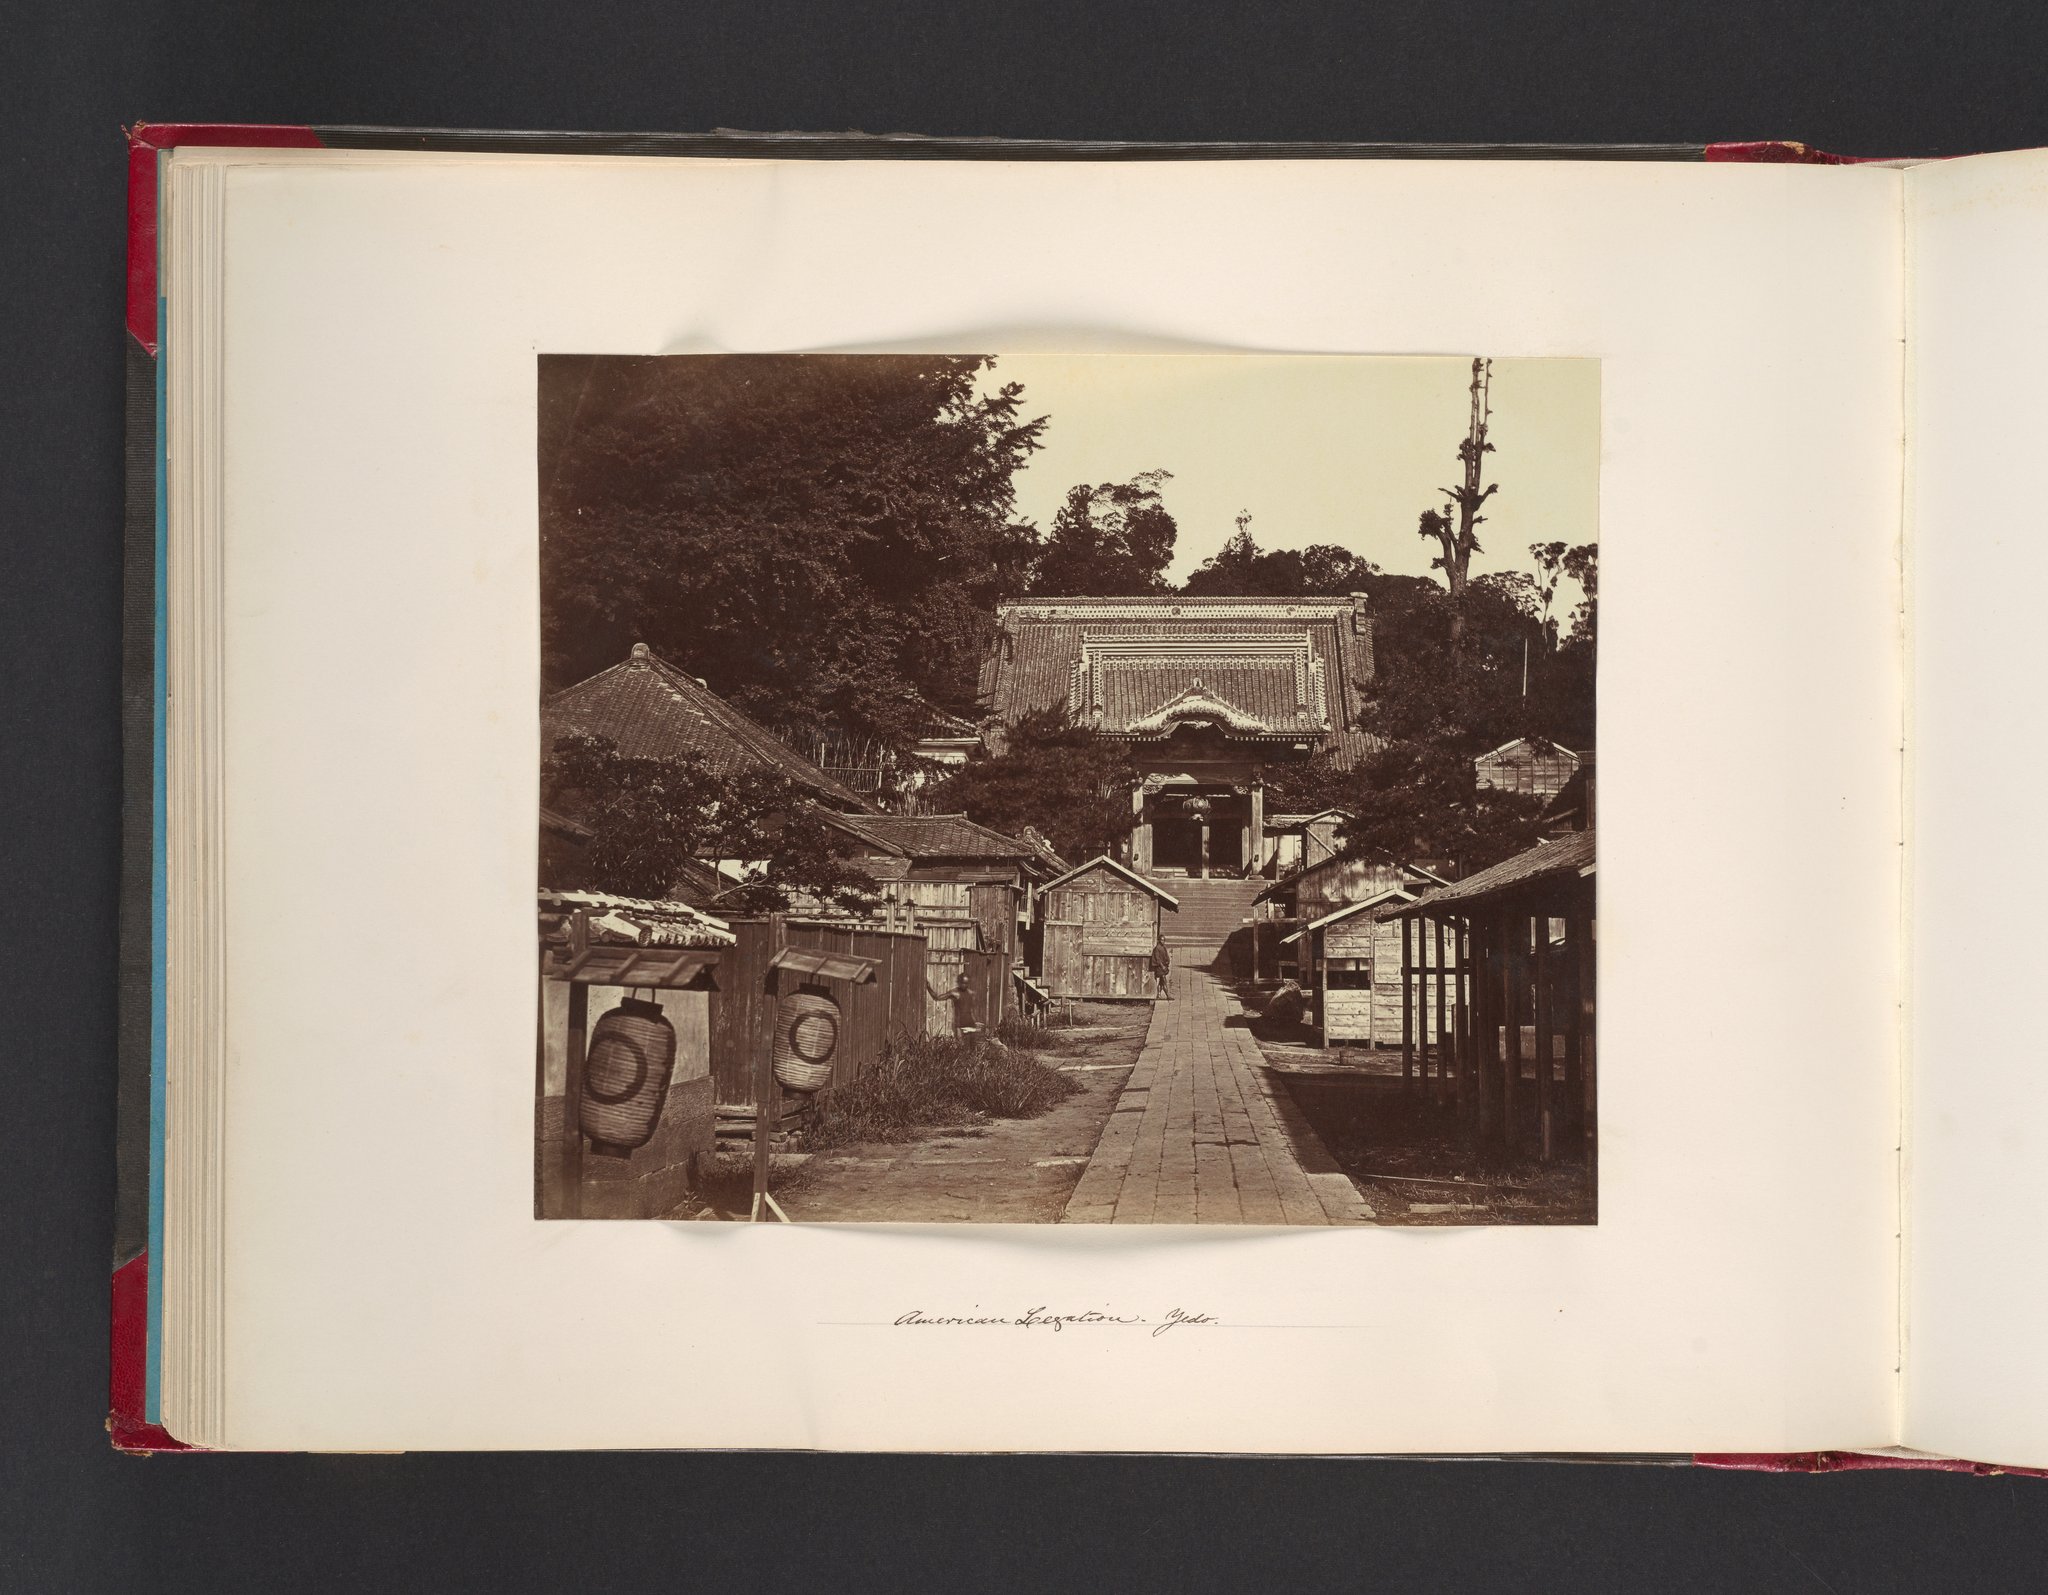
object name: photograph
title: American Legation, Yedo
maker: john thomson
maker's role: artist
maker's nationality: british, scottish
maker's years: 1837-1921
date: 1865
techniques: albumen silver print, glass negative